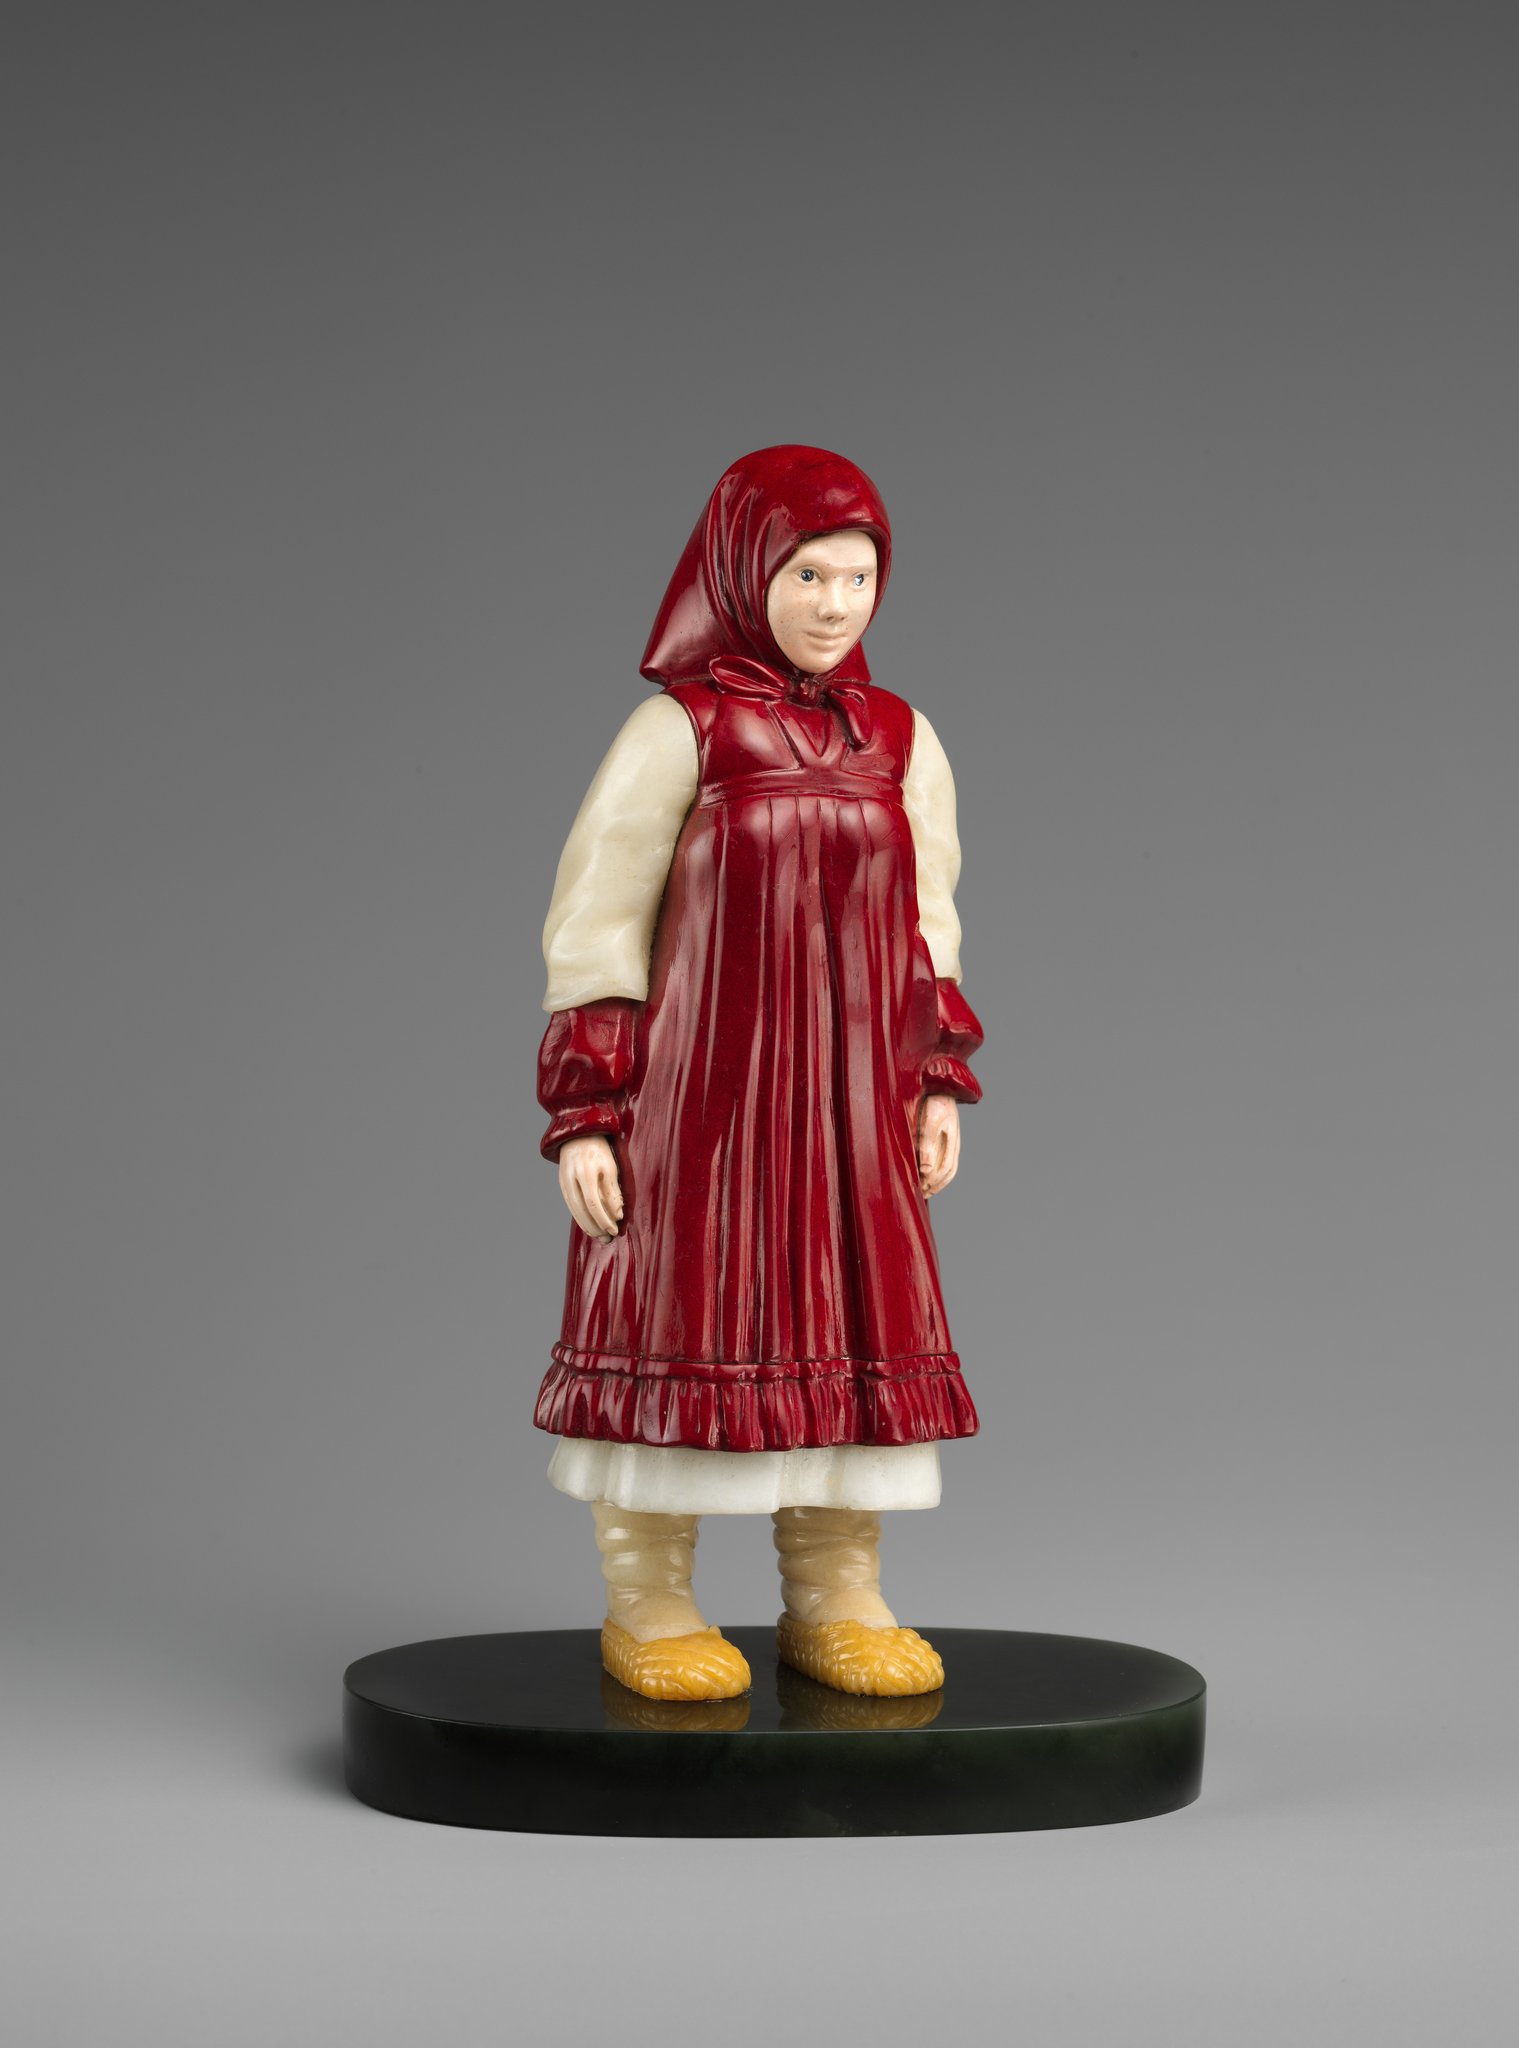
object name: figure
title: Russian peasant girl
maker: peter carl fabergé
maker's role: artist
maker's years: 1846-1920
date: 1910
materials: jade, jasper, gemstone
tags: girls